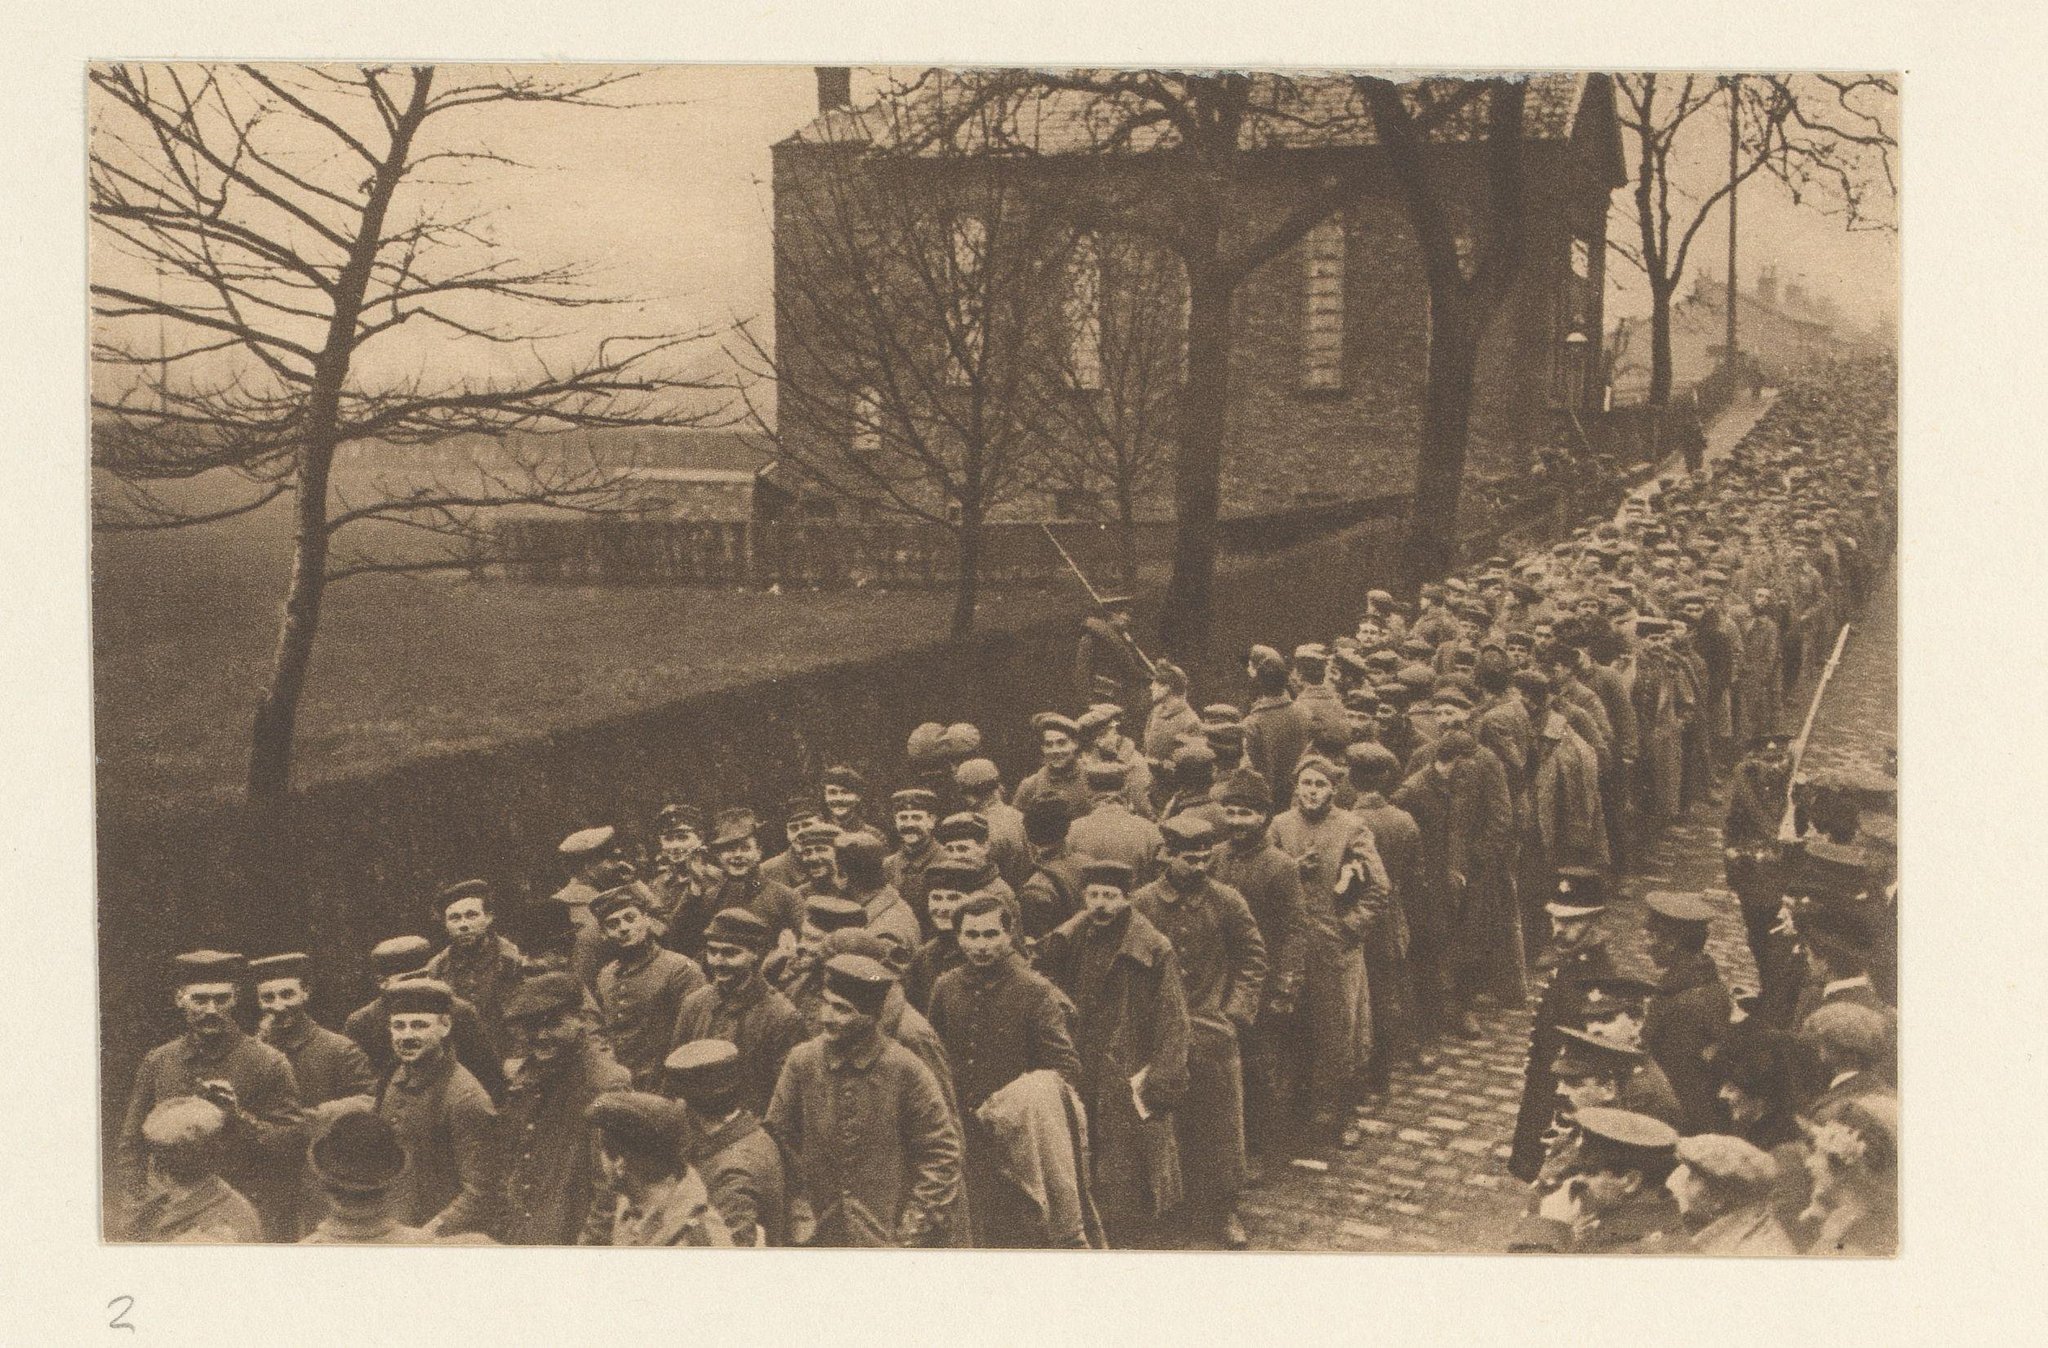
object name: ansichtkaart, prentbriefkaart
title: De gevechten van Neuve-Chapelle (9-13 maart 1915) in Vlaanderen waren een groot succes voor het Engelse leger (...) Krijgsgevangenen, gelukkig buiten gevaar te zijn, doorloopen een dorpje in Engeland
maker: sémaphore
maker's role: printer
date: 1915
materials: paper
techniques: photograph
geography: marseille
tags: transfer, deportation ~ prisoner of war, england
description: Duitse krijgsgevangenen trekken door een Engels dorp. Onderdeel van de tweede serie van twaalf (acht aanwezig) prentbriefkaarten over de Eerste Wereldoorlog, 1915.